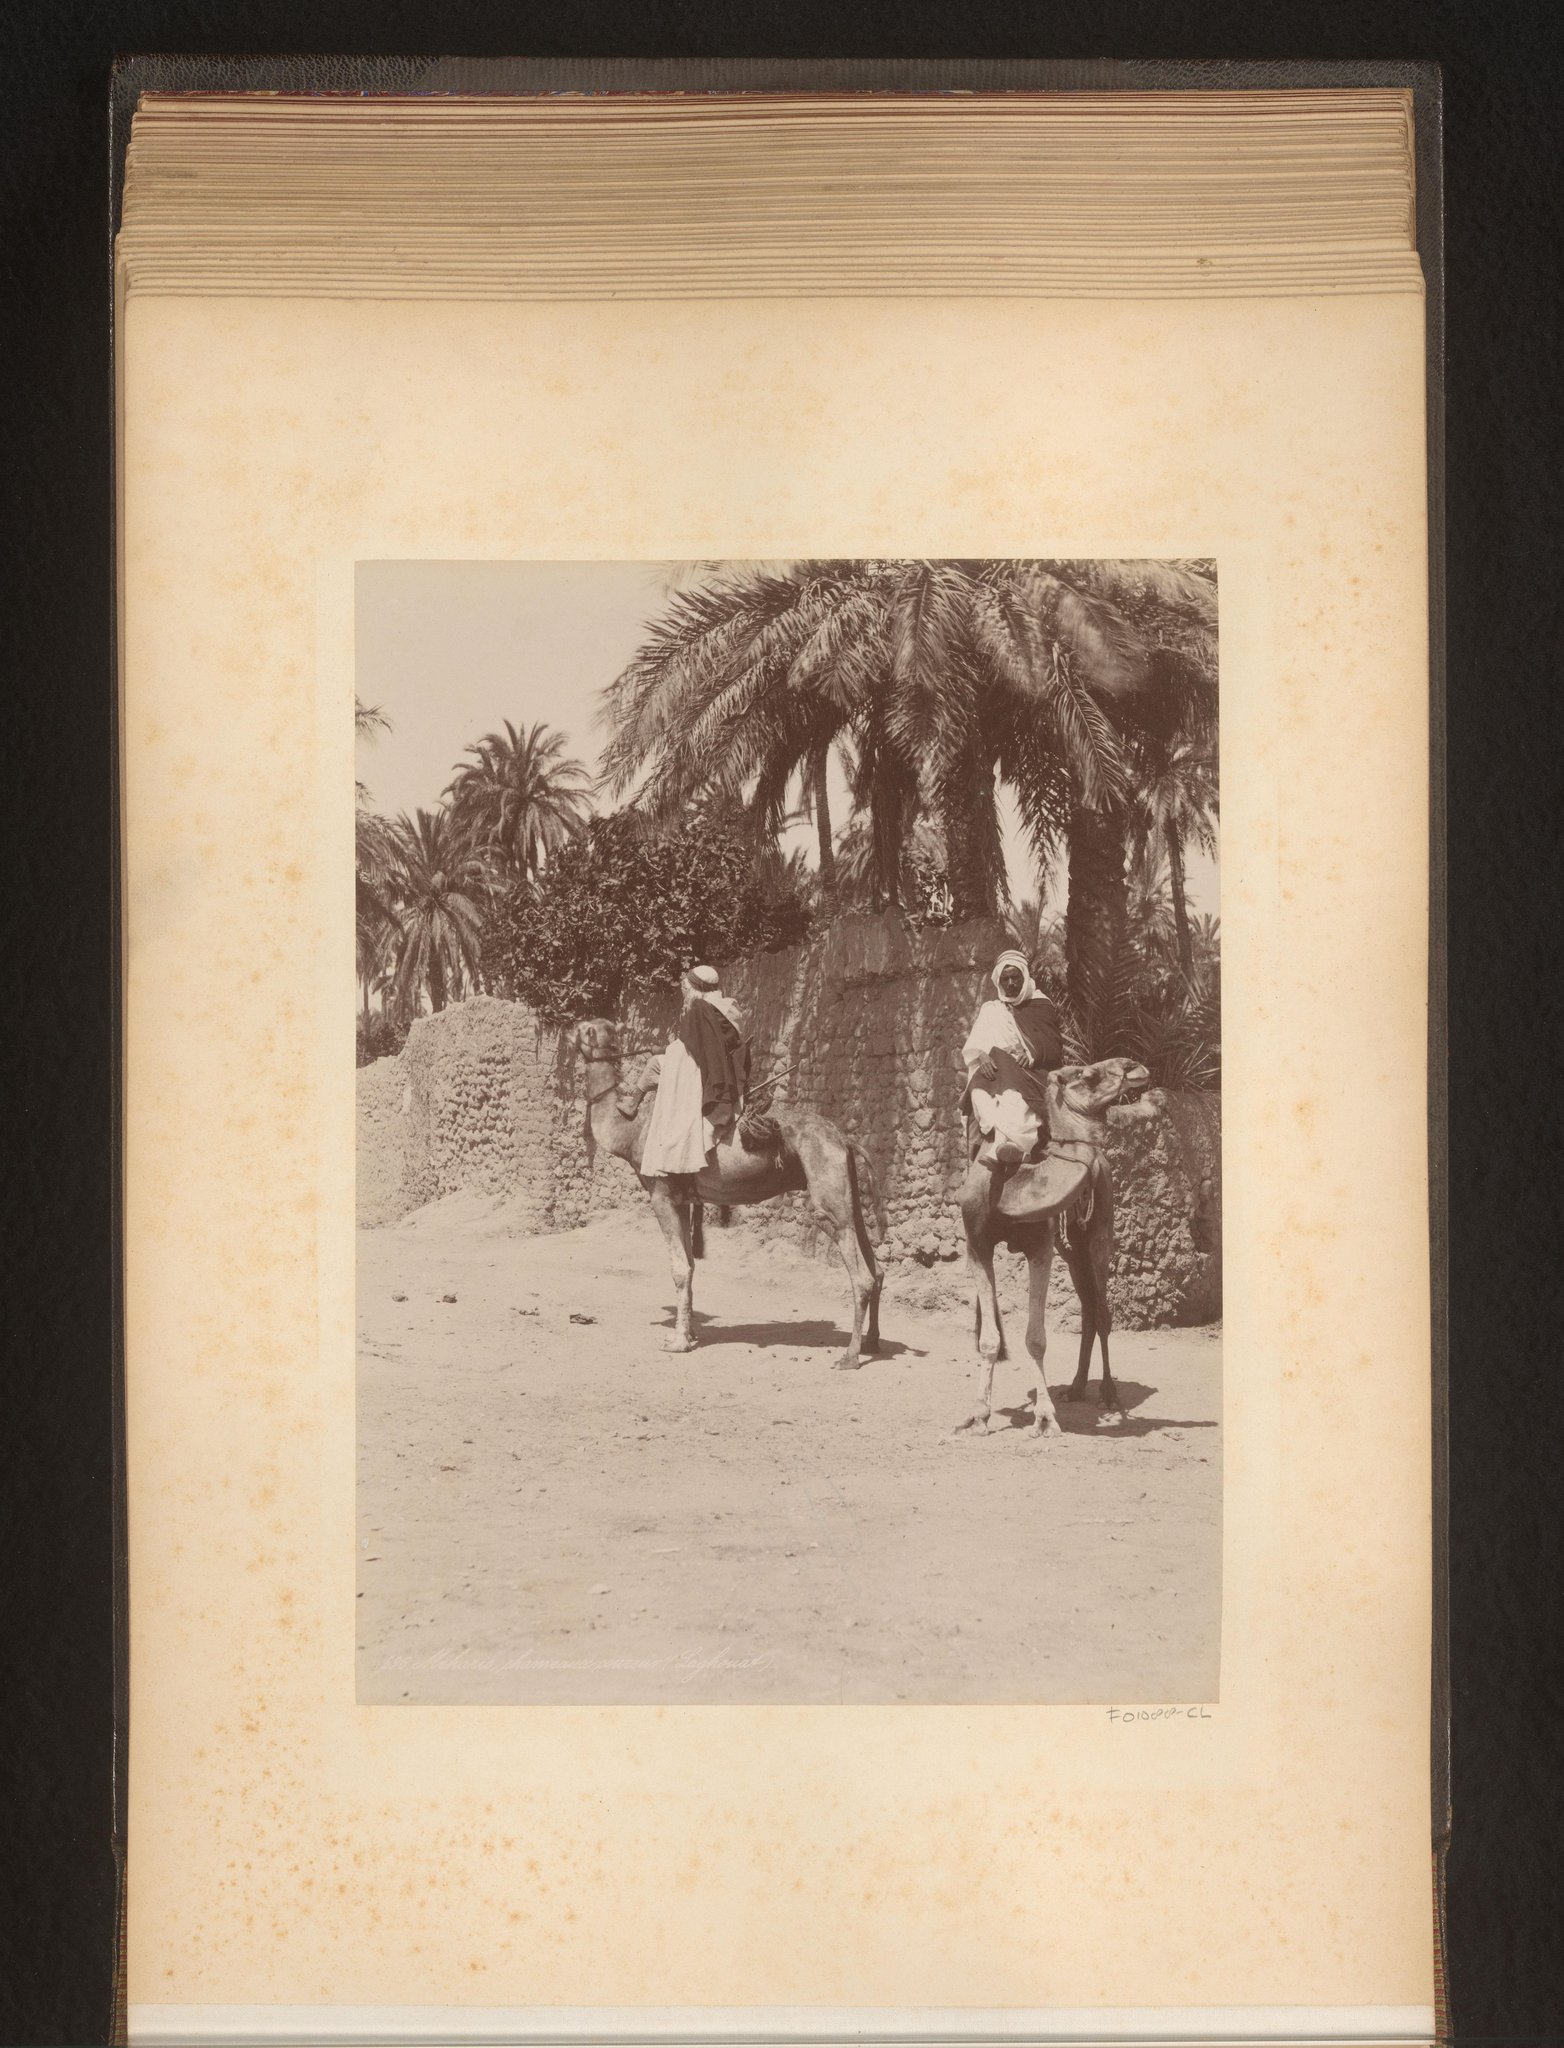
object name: album leaf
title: Twee mannen op dromedarissen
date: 1880-1900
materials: photographic support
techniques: albumen print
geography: algeria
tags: hoofed animals: dromedary, adult man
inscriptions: number: ‘596’, check stamp: ‘J. Kuhn Editeur/ 220 Rue de Rivoli Paris’